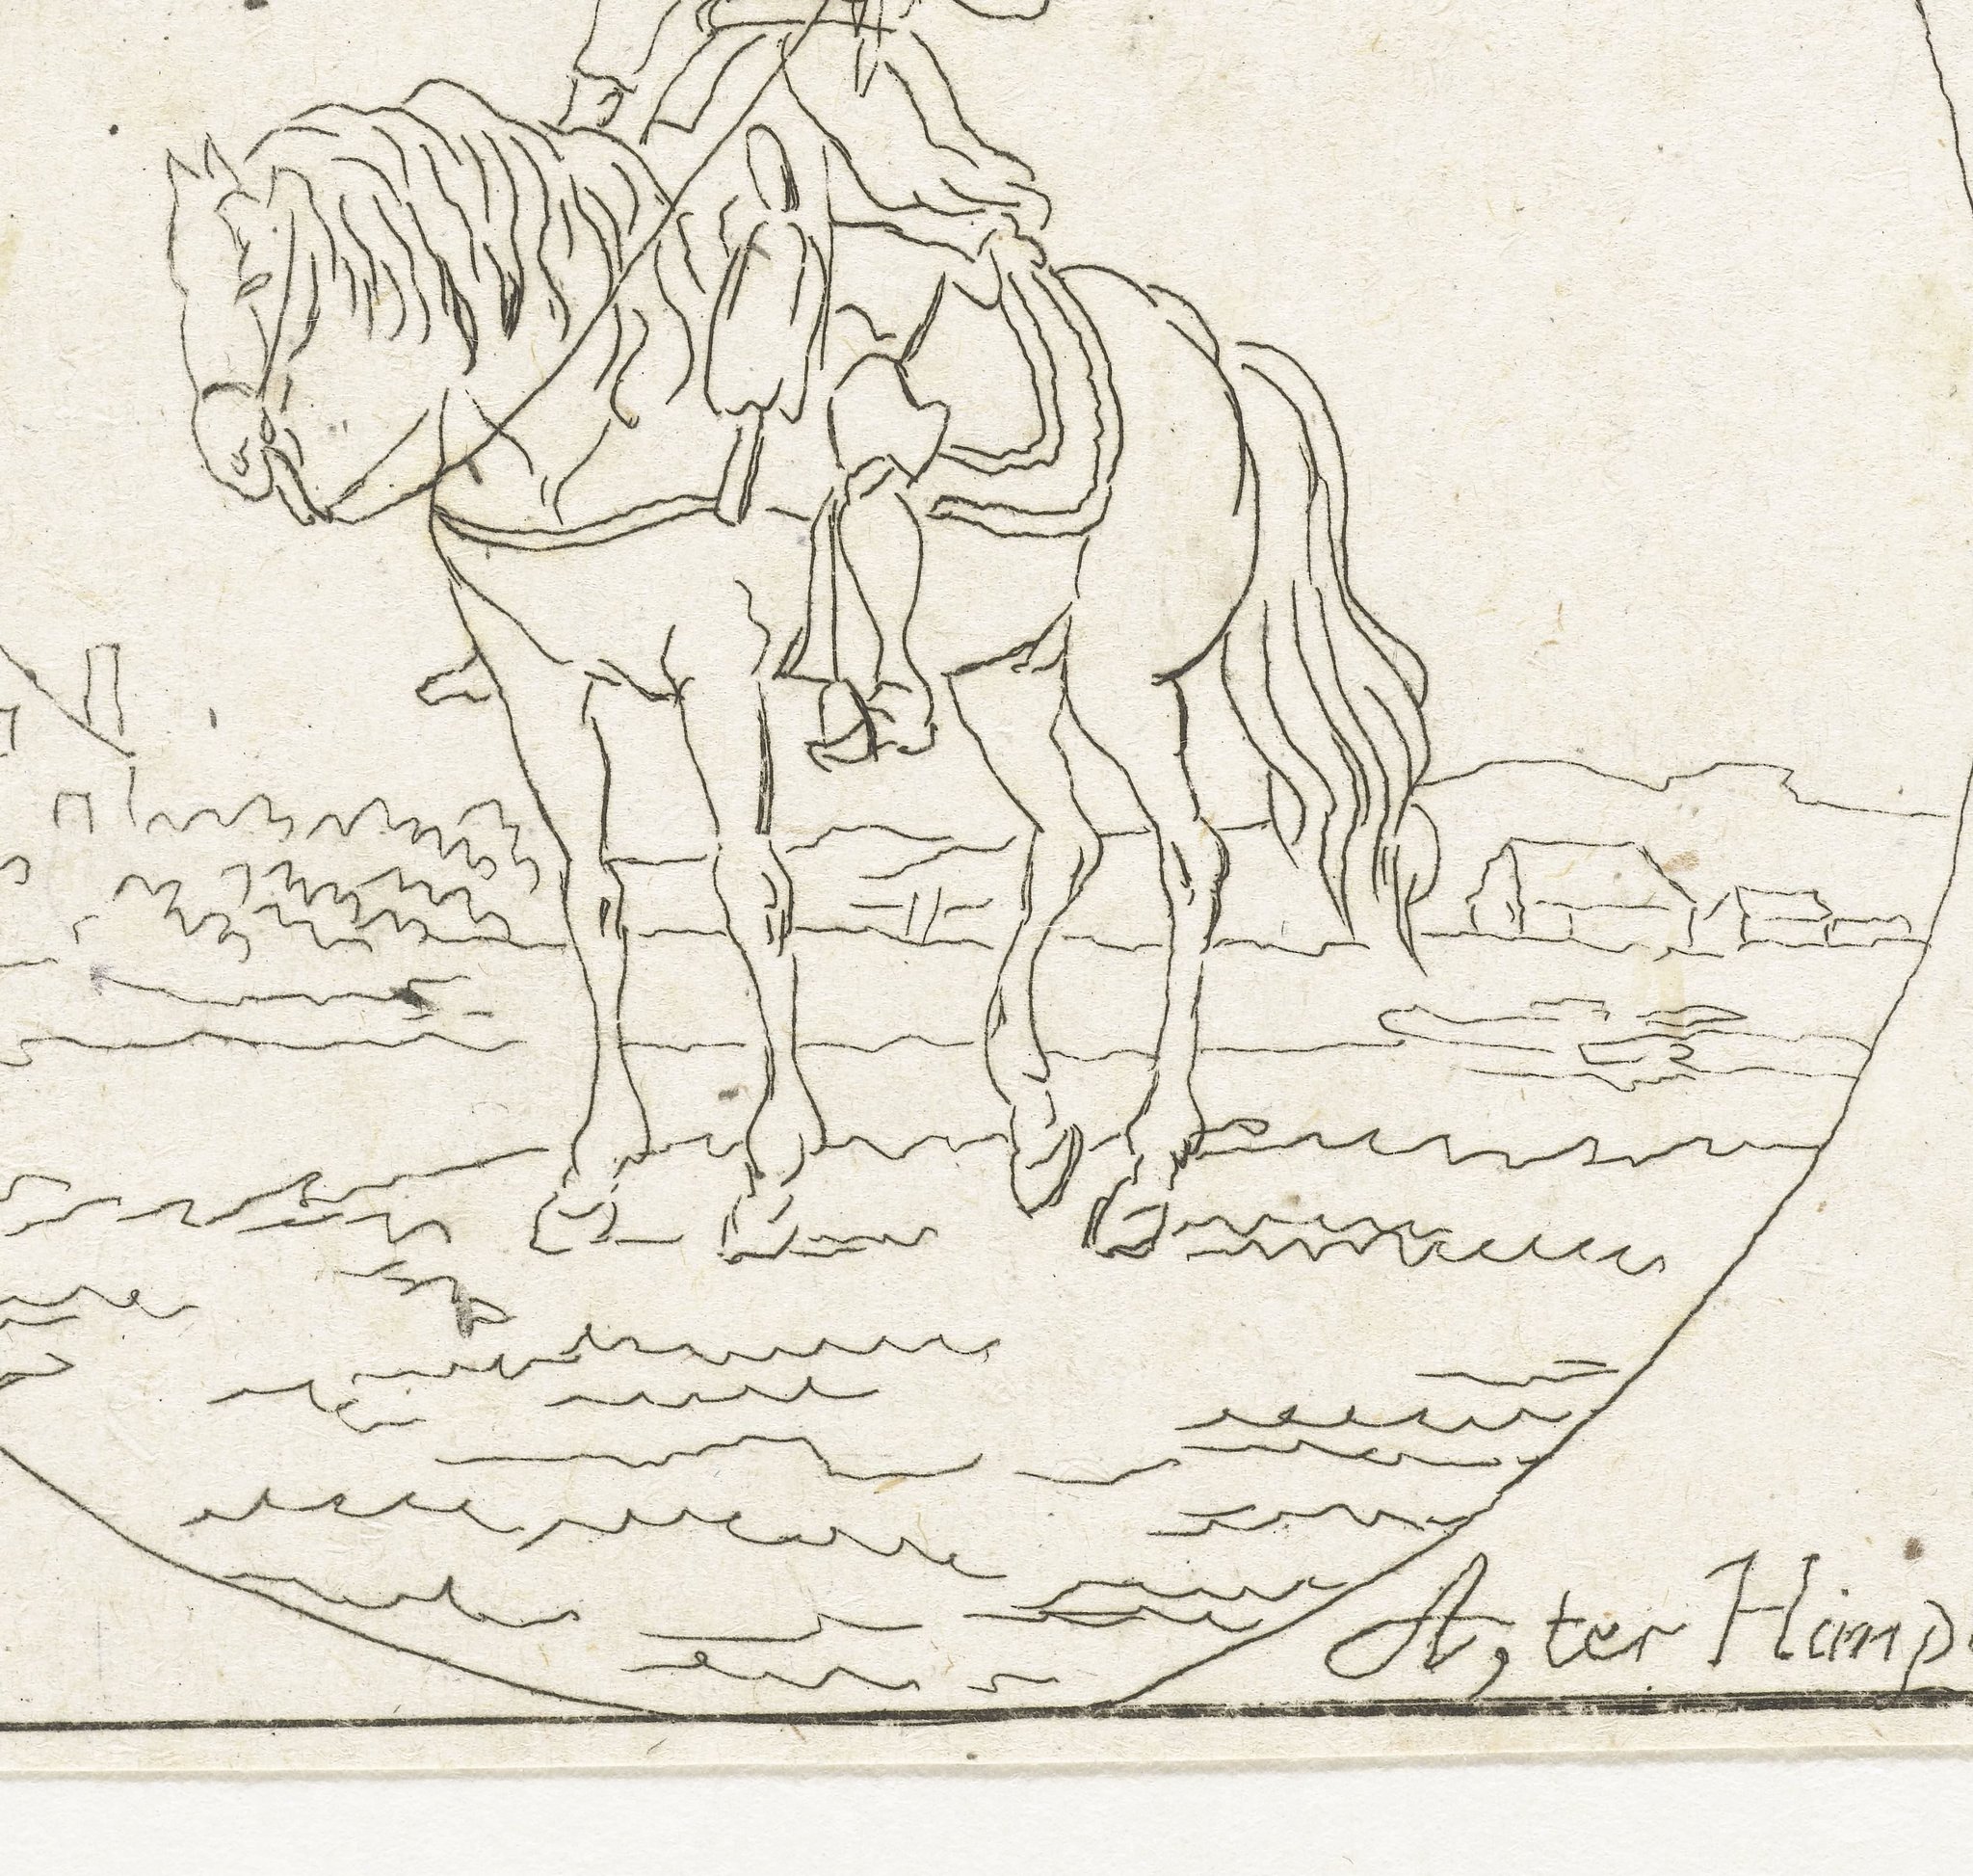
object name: print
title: Ruiter op staand paard in medaillon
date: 1778-1838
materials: paper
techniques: etching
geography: netherlands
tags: riding a horse, ass, or mule; rider, horseman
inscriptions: collector's mark: Lugt 2228